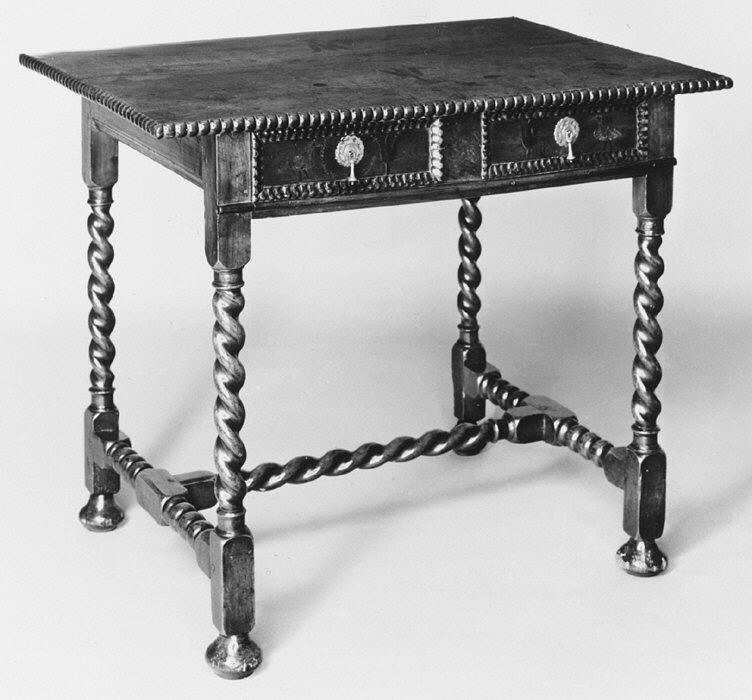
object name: table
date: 1667-1700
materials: wood